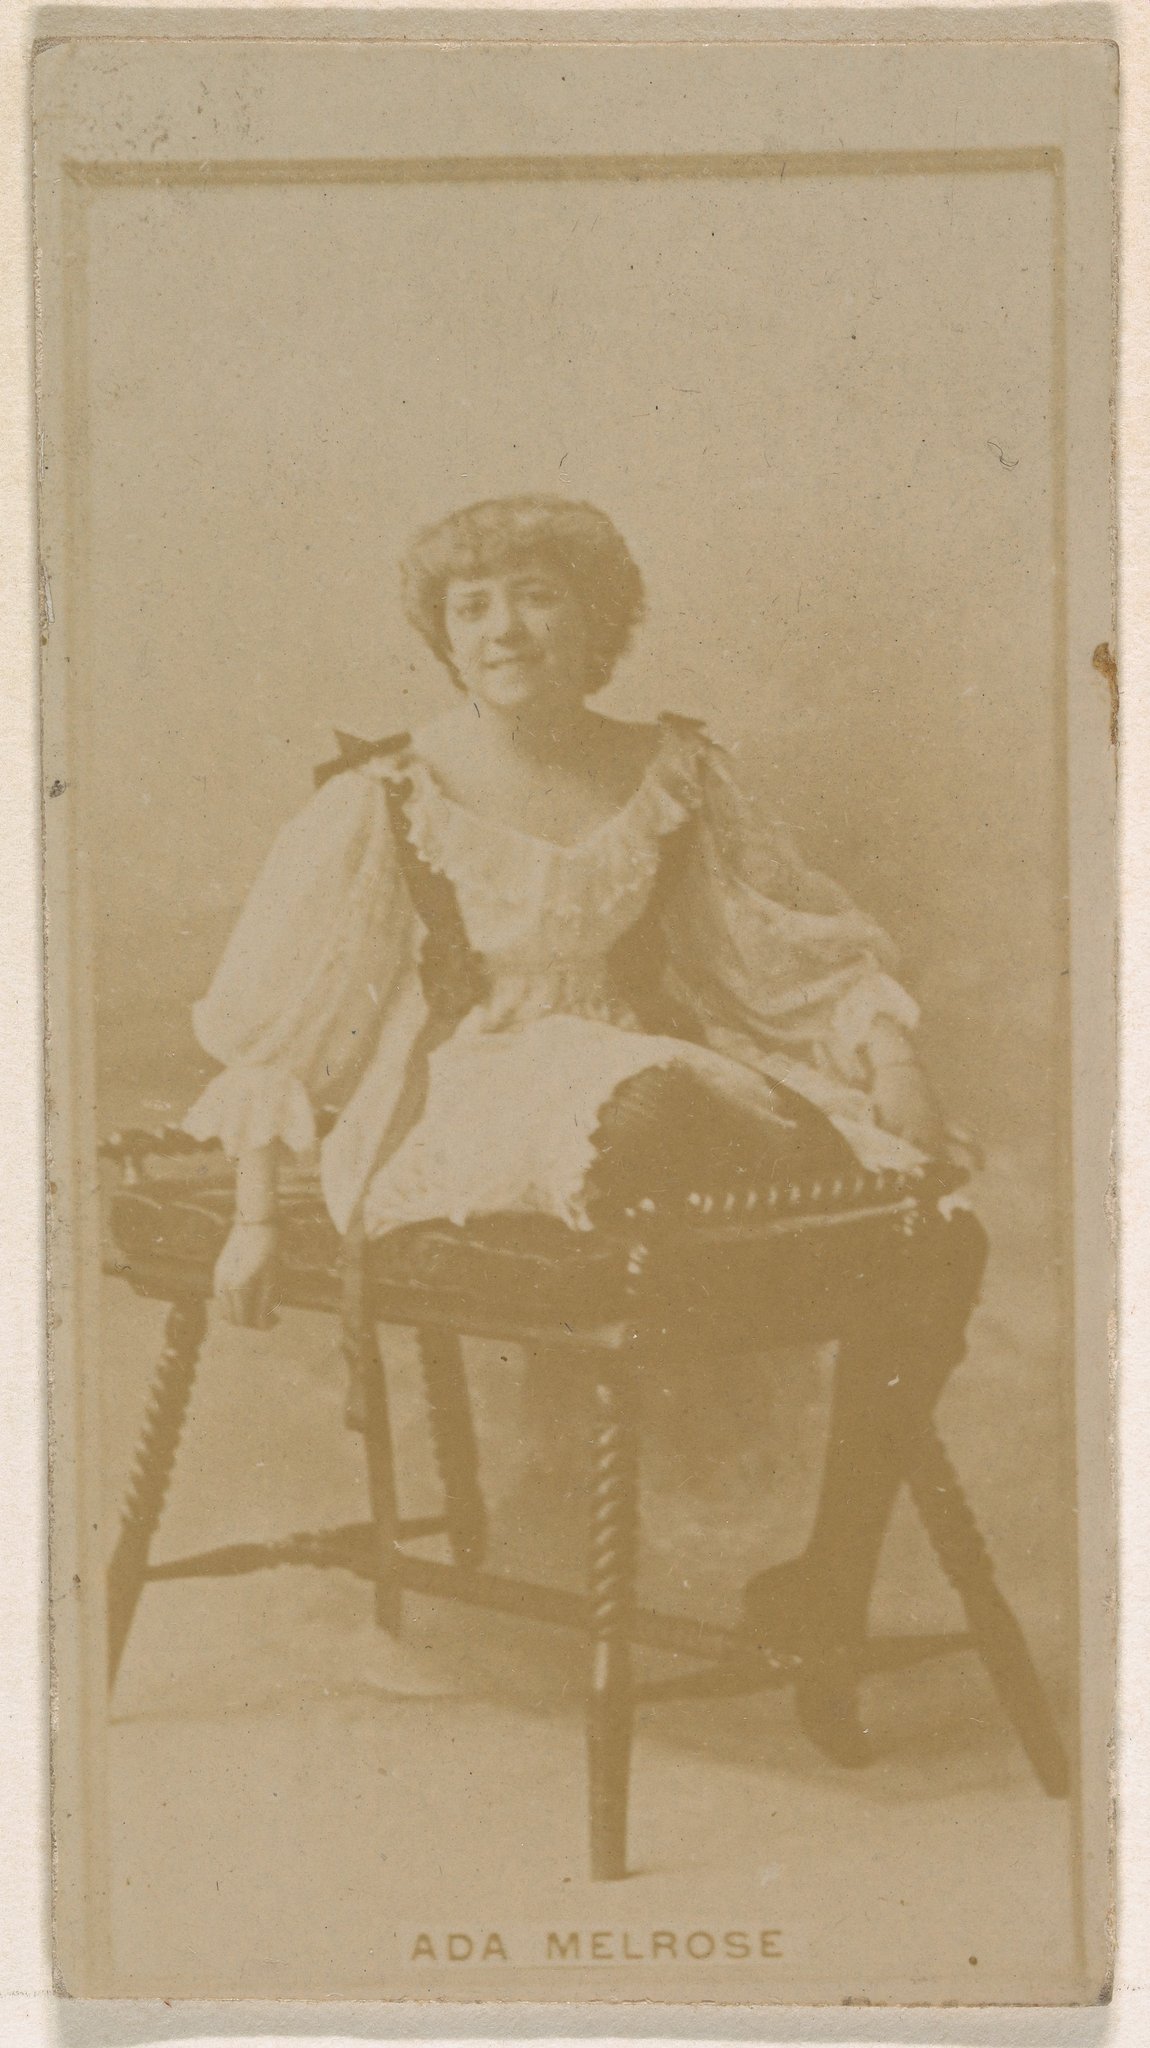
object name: photograph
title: Ada Melrose, from the Actresses series (N245) issued by Kinney Brothers to promote Sweet Caporal Cigarettes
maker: kinney brothers tobacco company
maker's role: publisher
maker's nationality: american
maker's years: 1869-2011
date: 1890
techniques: albumen silver print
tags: portraits,women,actresses